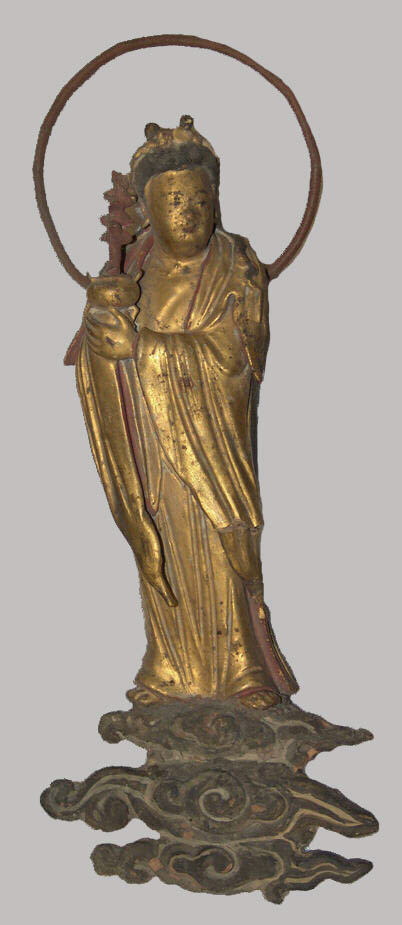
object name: figure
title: Figure of Attendant Deity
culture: chinese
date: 1368-1644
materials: mud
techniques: gilding, painting